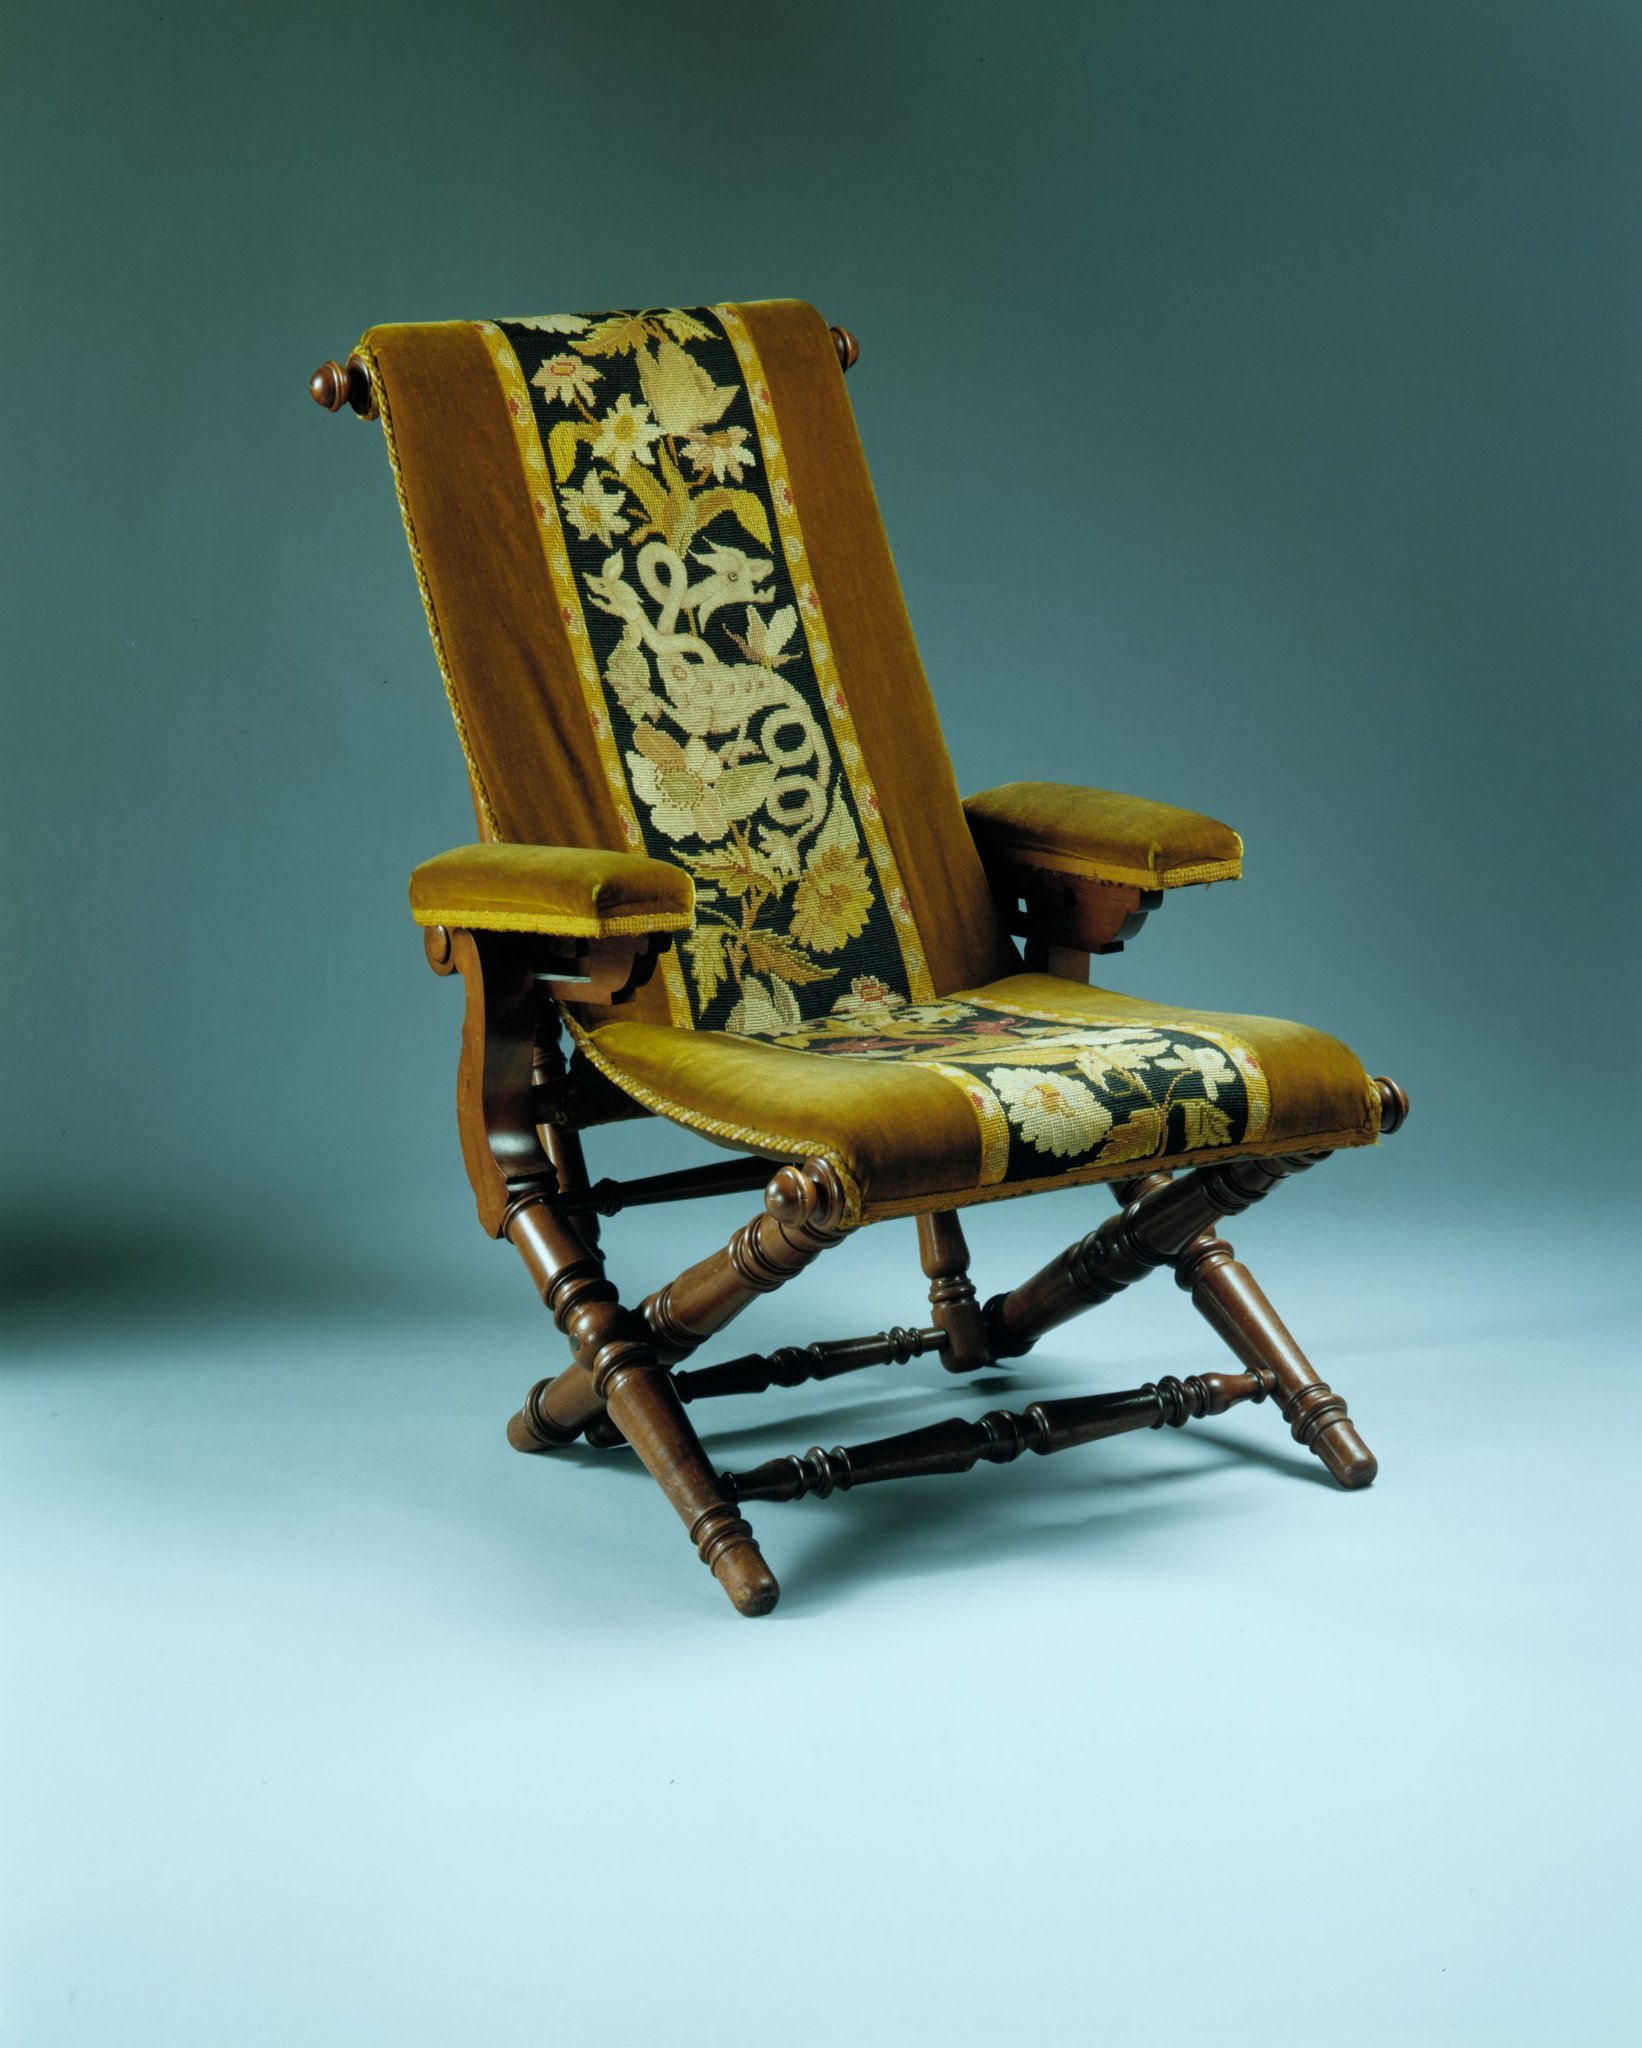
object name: reclining armchair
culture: american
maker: george jakob hunzinger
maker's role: maker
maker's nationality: american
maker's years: 1835-1898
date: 1866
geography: united states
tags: flowers